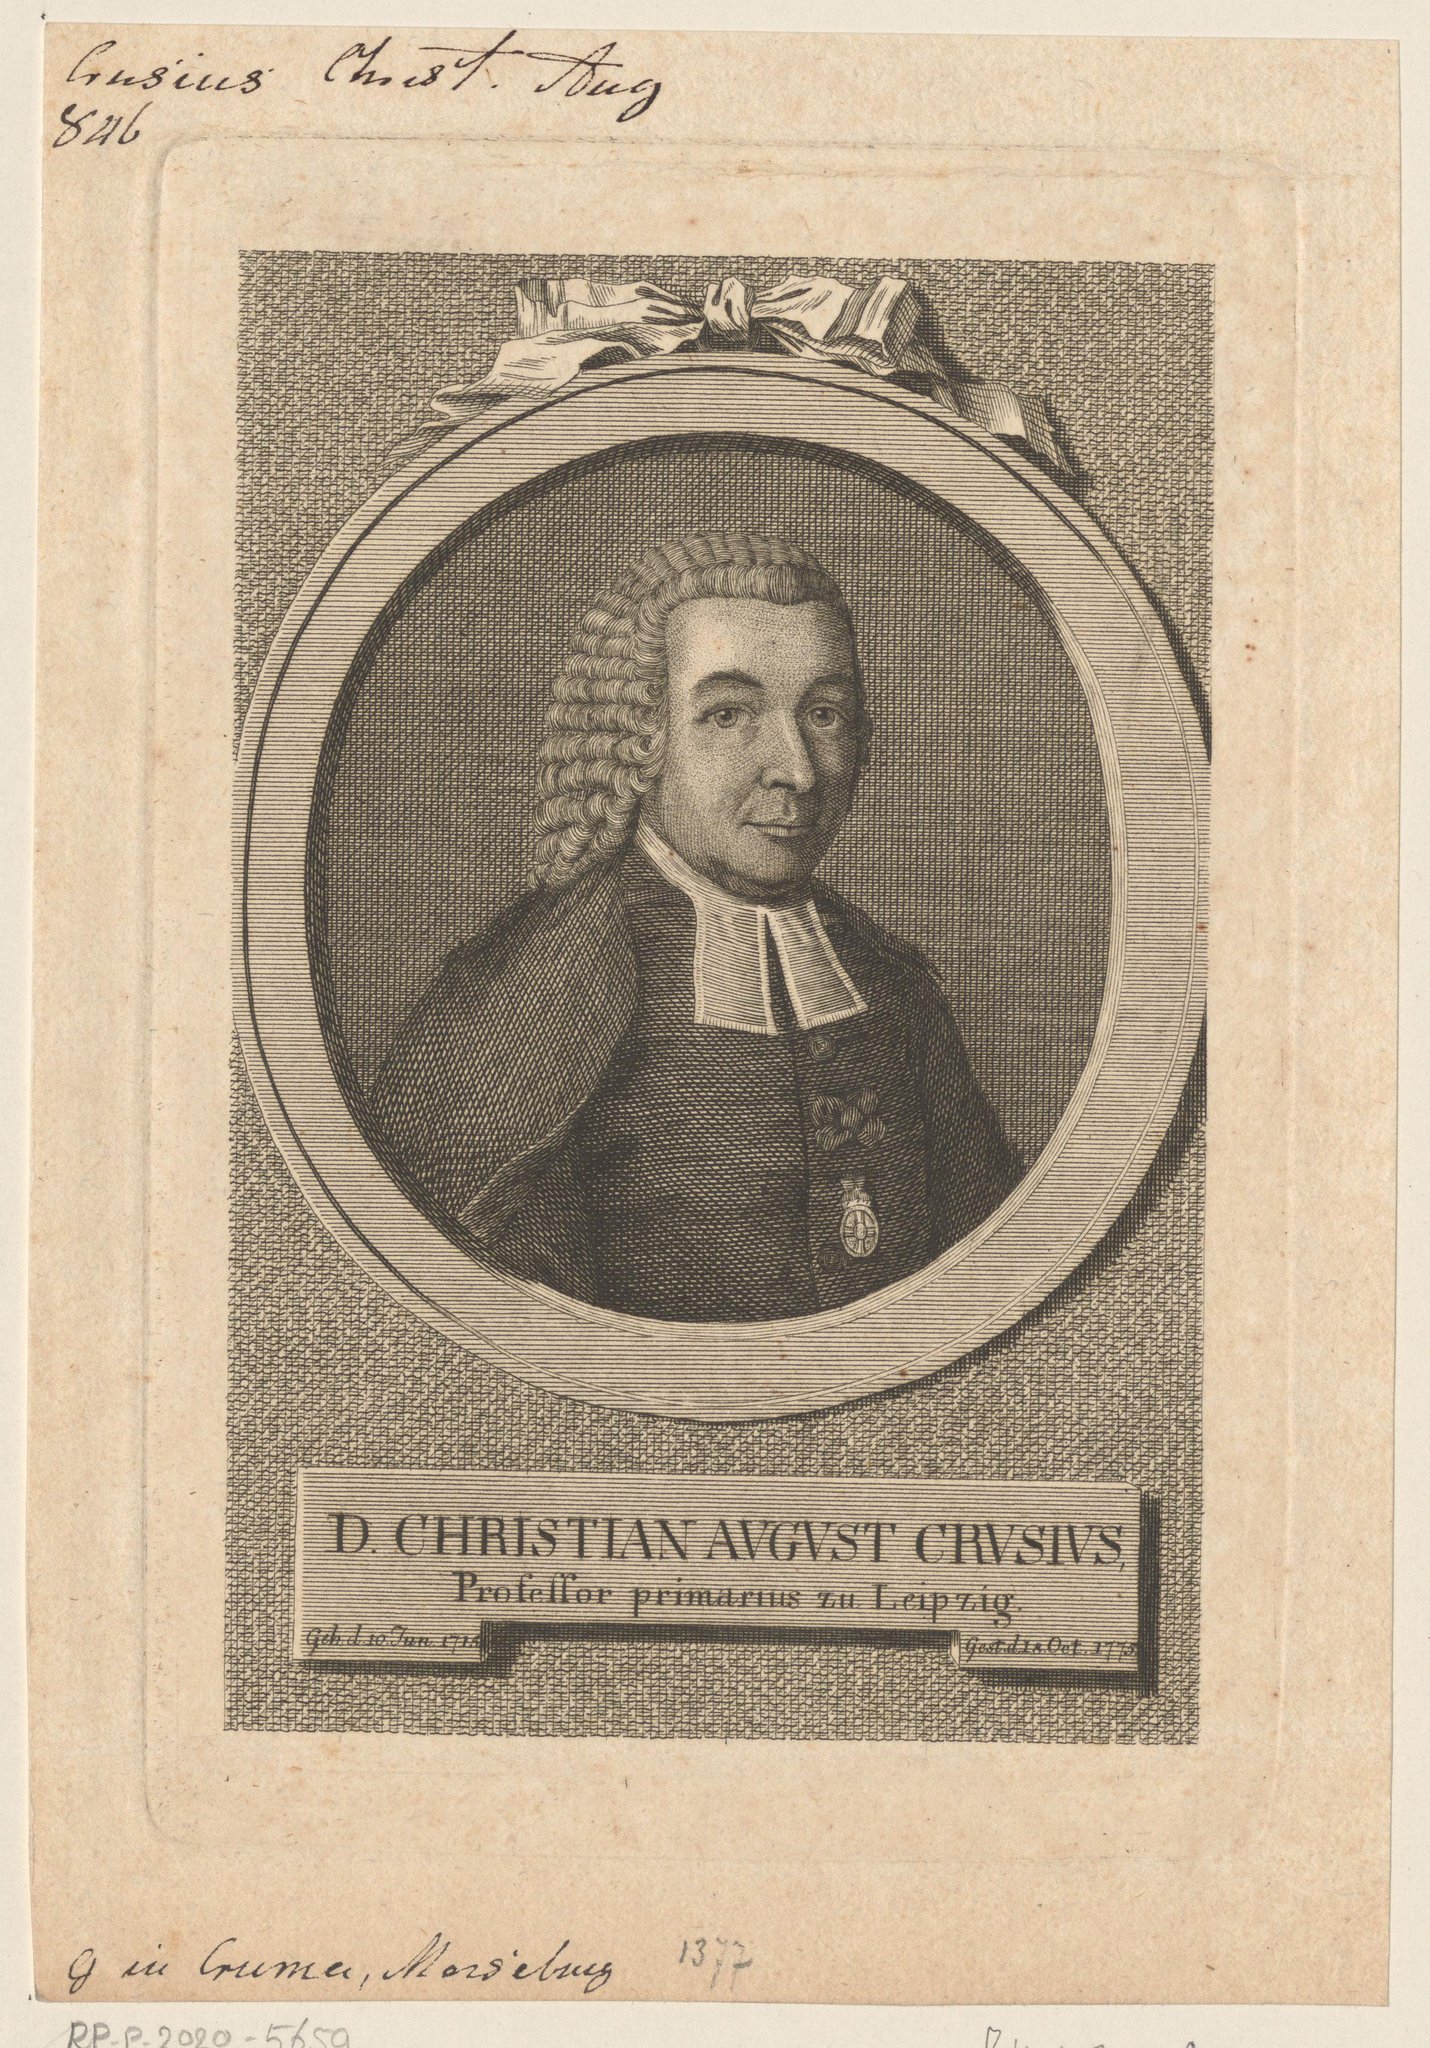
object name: print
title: Portret van Christian August Crusius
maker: Anonymous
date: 1775-1799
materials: paper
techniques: engraving, etching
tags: historical persons